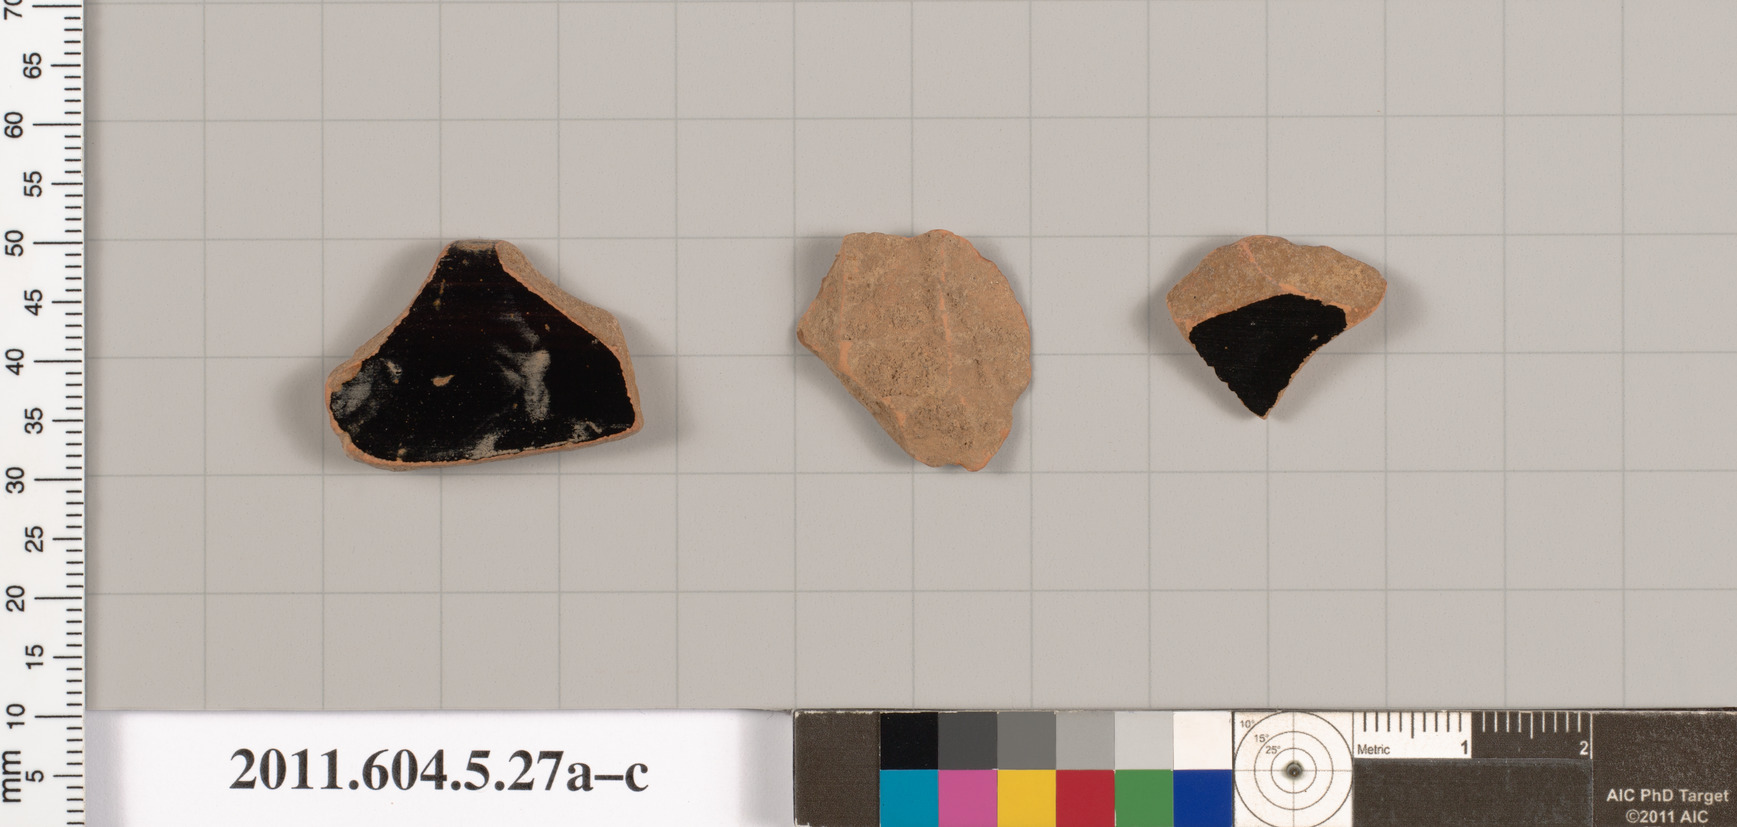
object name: kylix fragment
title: Terracotta fragments of kylikes (drinking cups)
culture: greek, attic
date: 534-501 BCE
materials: terracotta